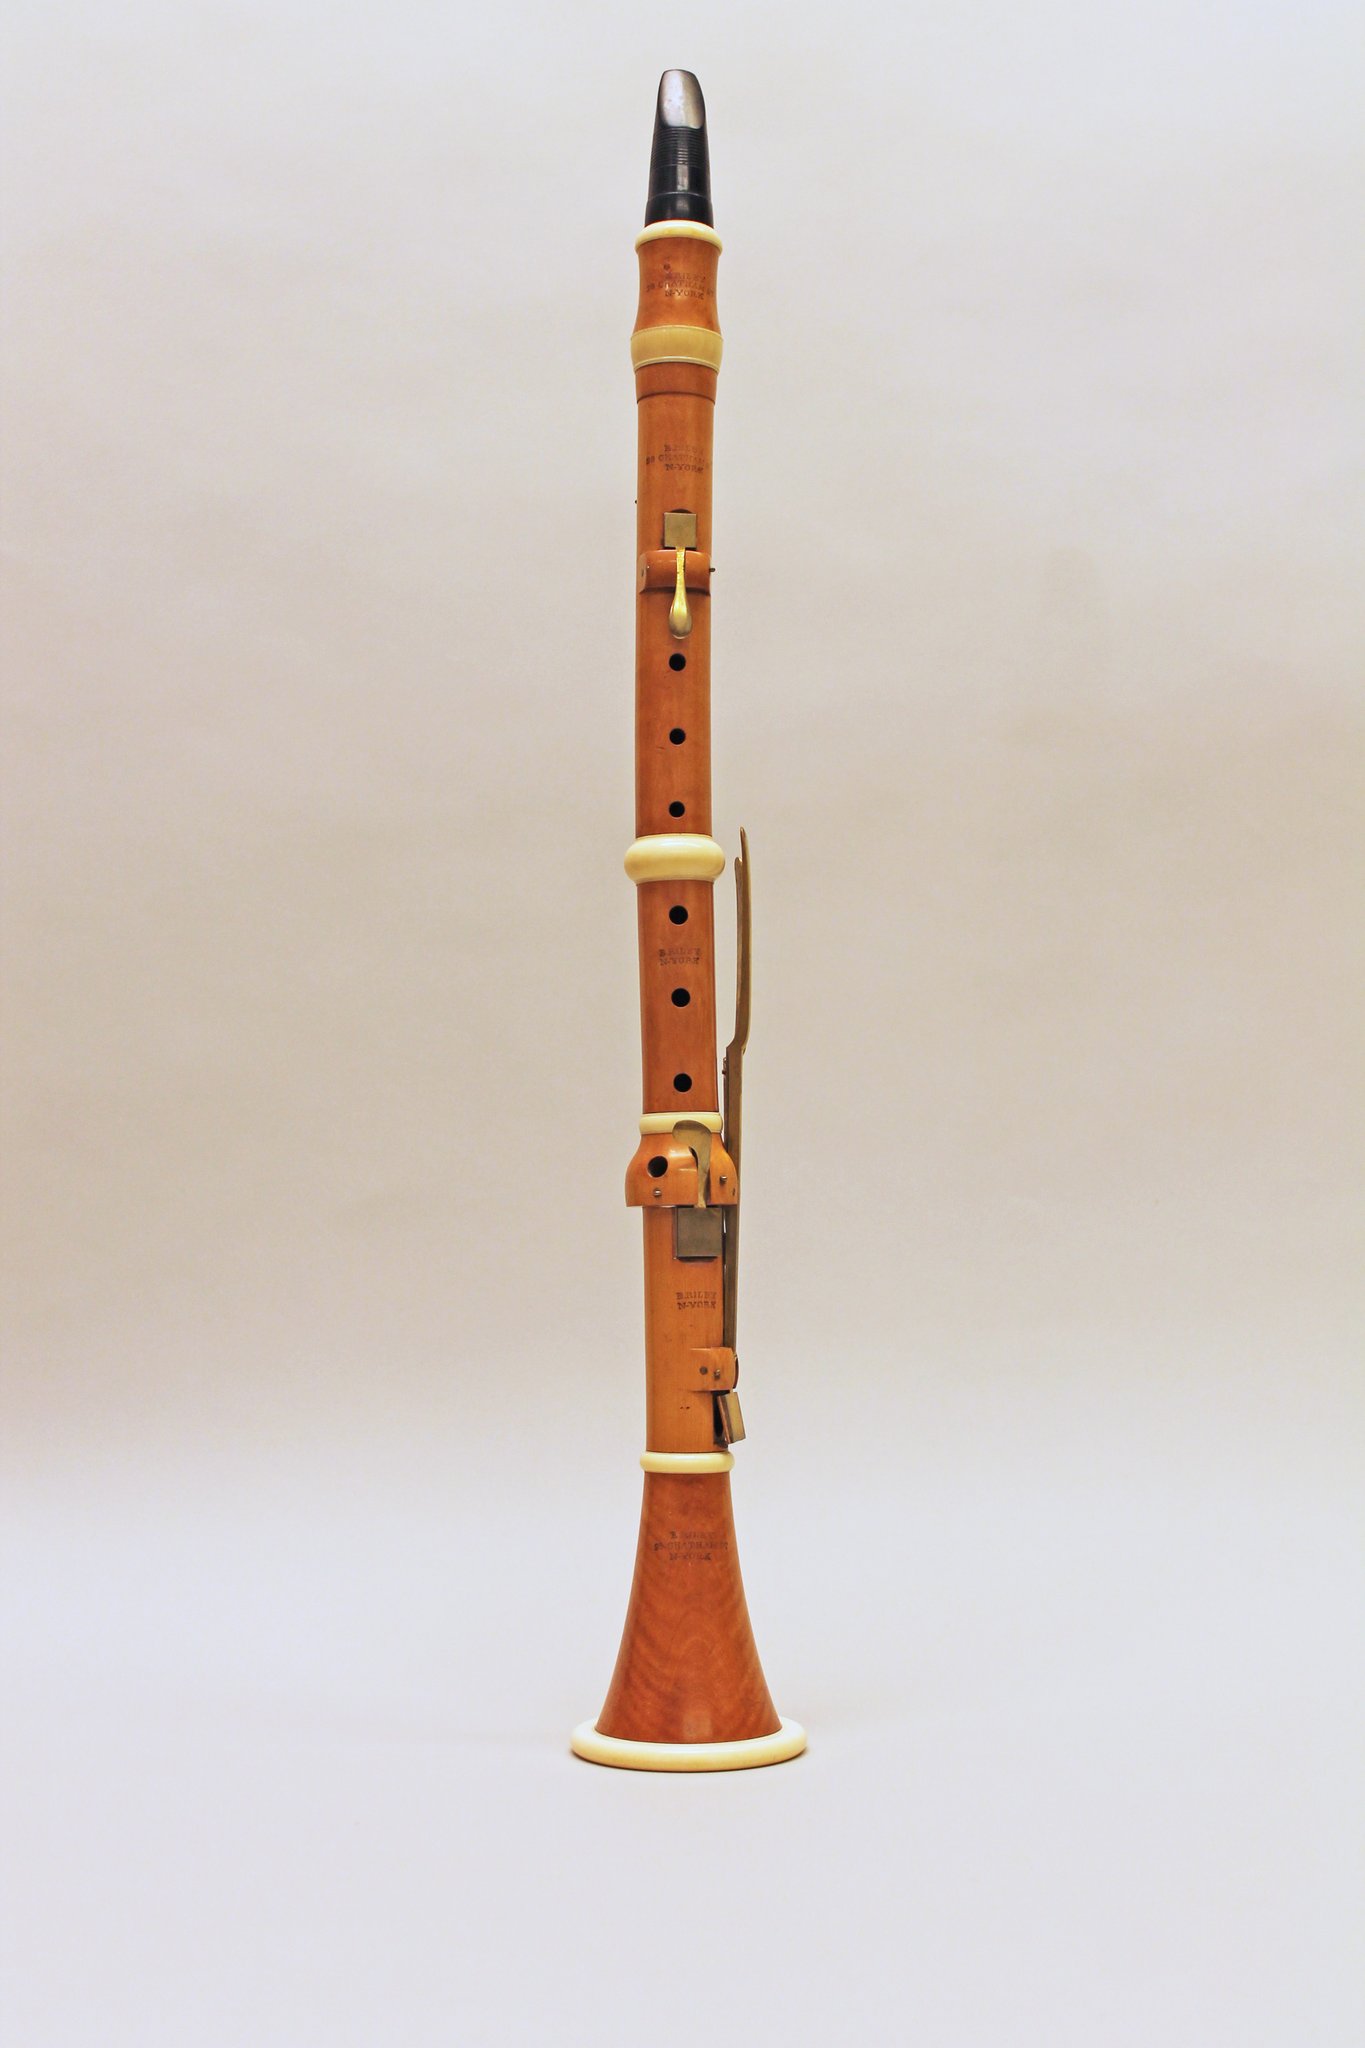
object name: clarinet in c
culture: american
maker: edward riley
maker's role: maker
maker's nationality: american, born england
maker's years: 1769-1829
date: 1825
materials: wood, brass, ivory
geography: united states